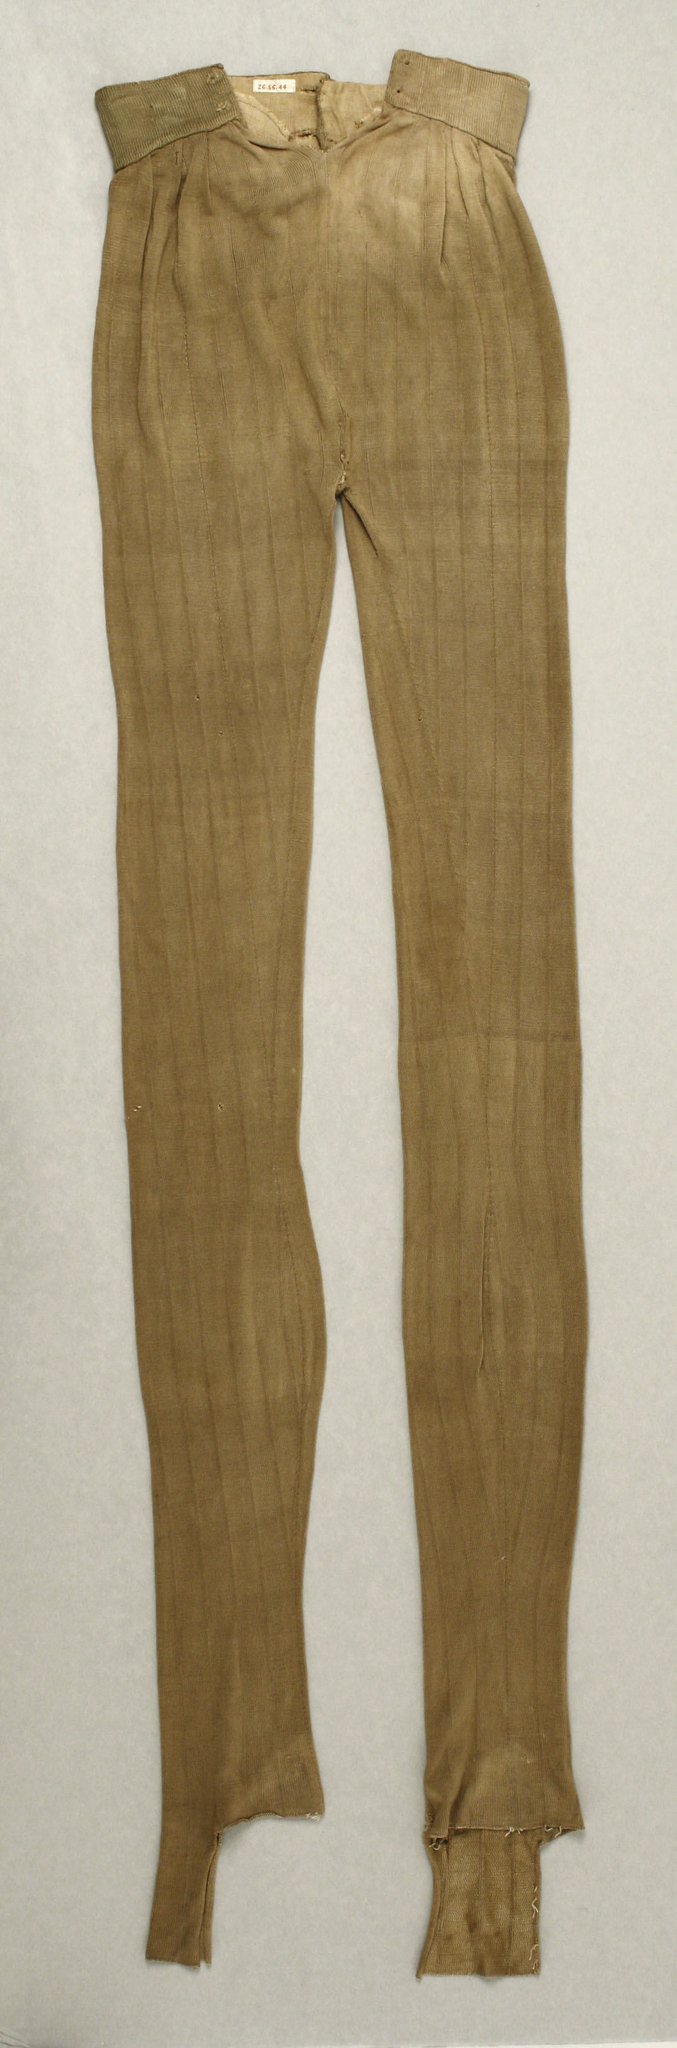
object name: tights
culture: italian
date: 1801-1833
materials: cotton